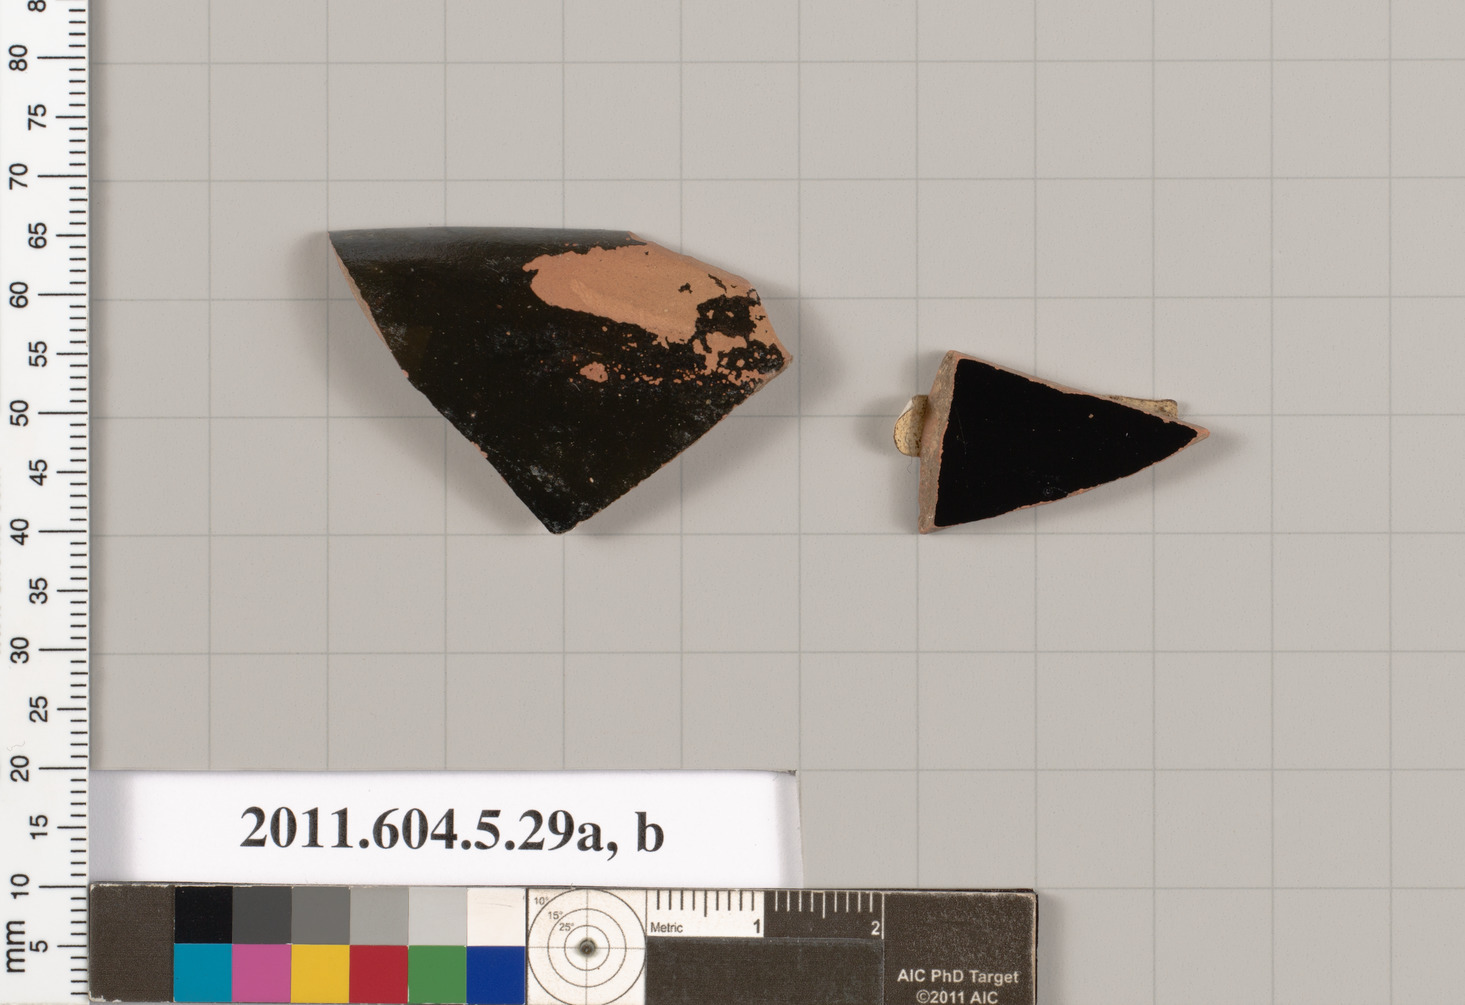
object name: kylix fragment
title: Terracotta fragments of kylikes (drinking cups)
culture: greek, attic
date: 475-451 BCE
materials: terracotta